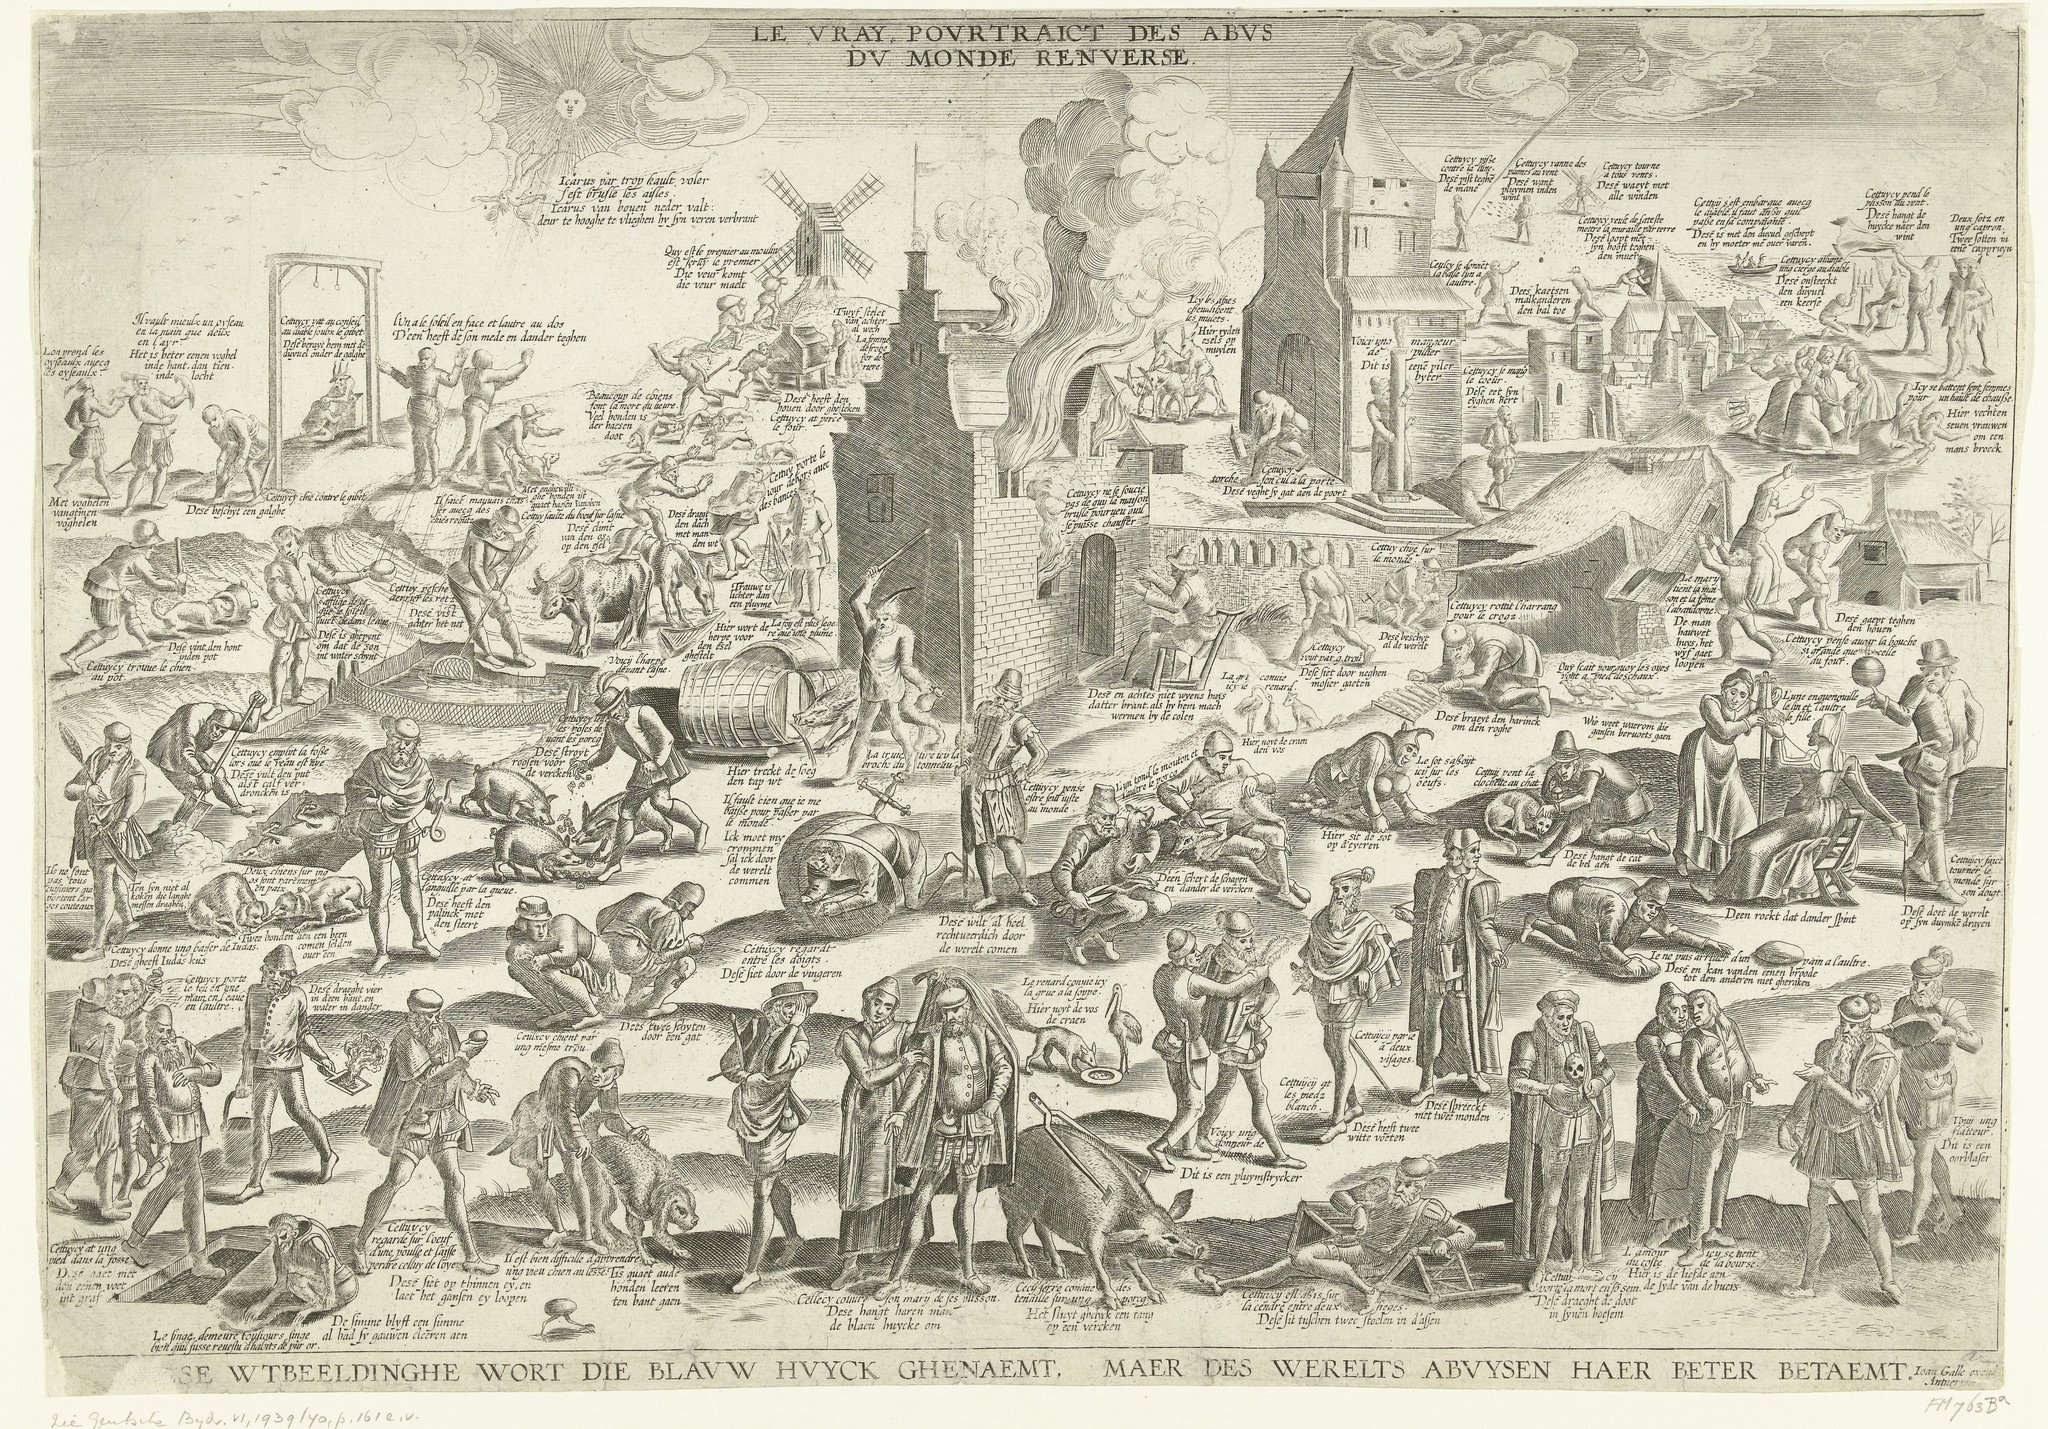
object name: print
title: Le vray pourtraict des abus du monde renverse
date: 1640-1660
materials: paper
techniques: engraving, etching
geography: antwerp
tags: proverbs, sayings, etc.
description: De Blauwe Huyck, 71 spreekwoorden verbeeld in een fantasielandschap. Met opschriften in het Frans en Nederlands bij elk spreekwoord.